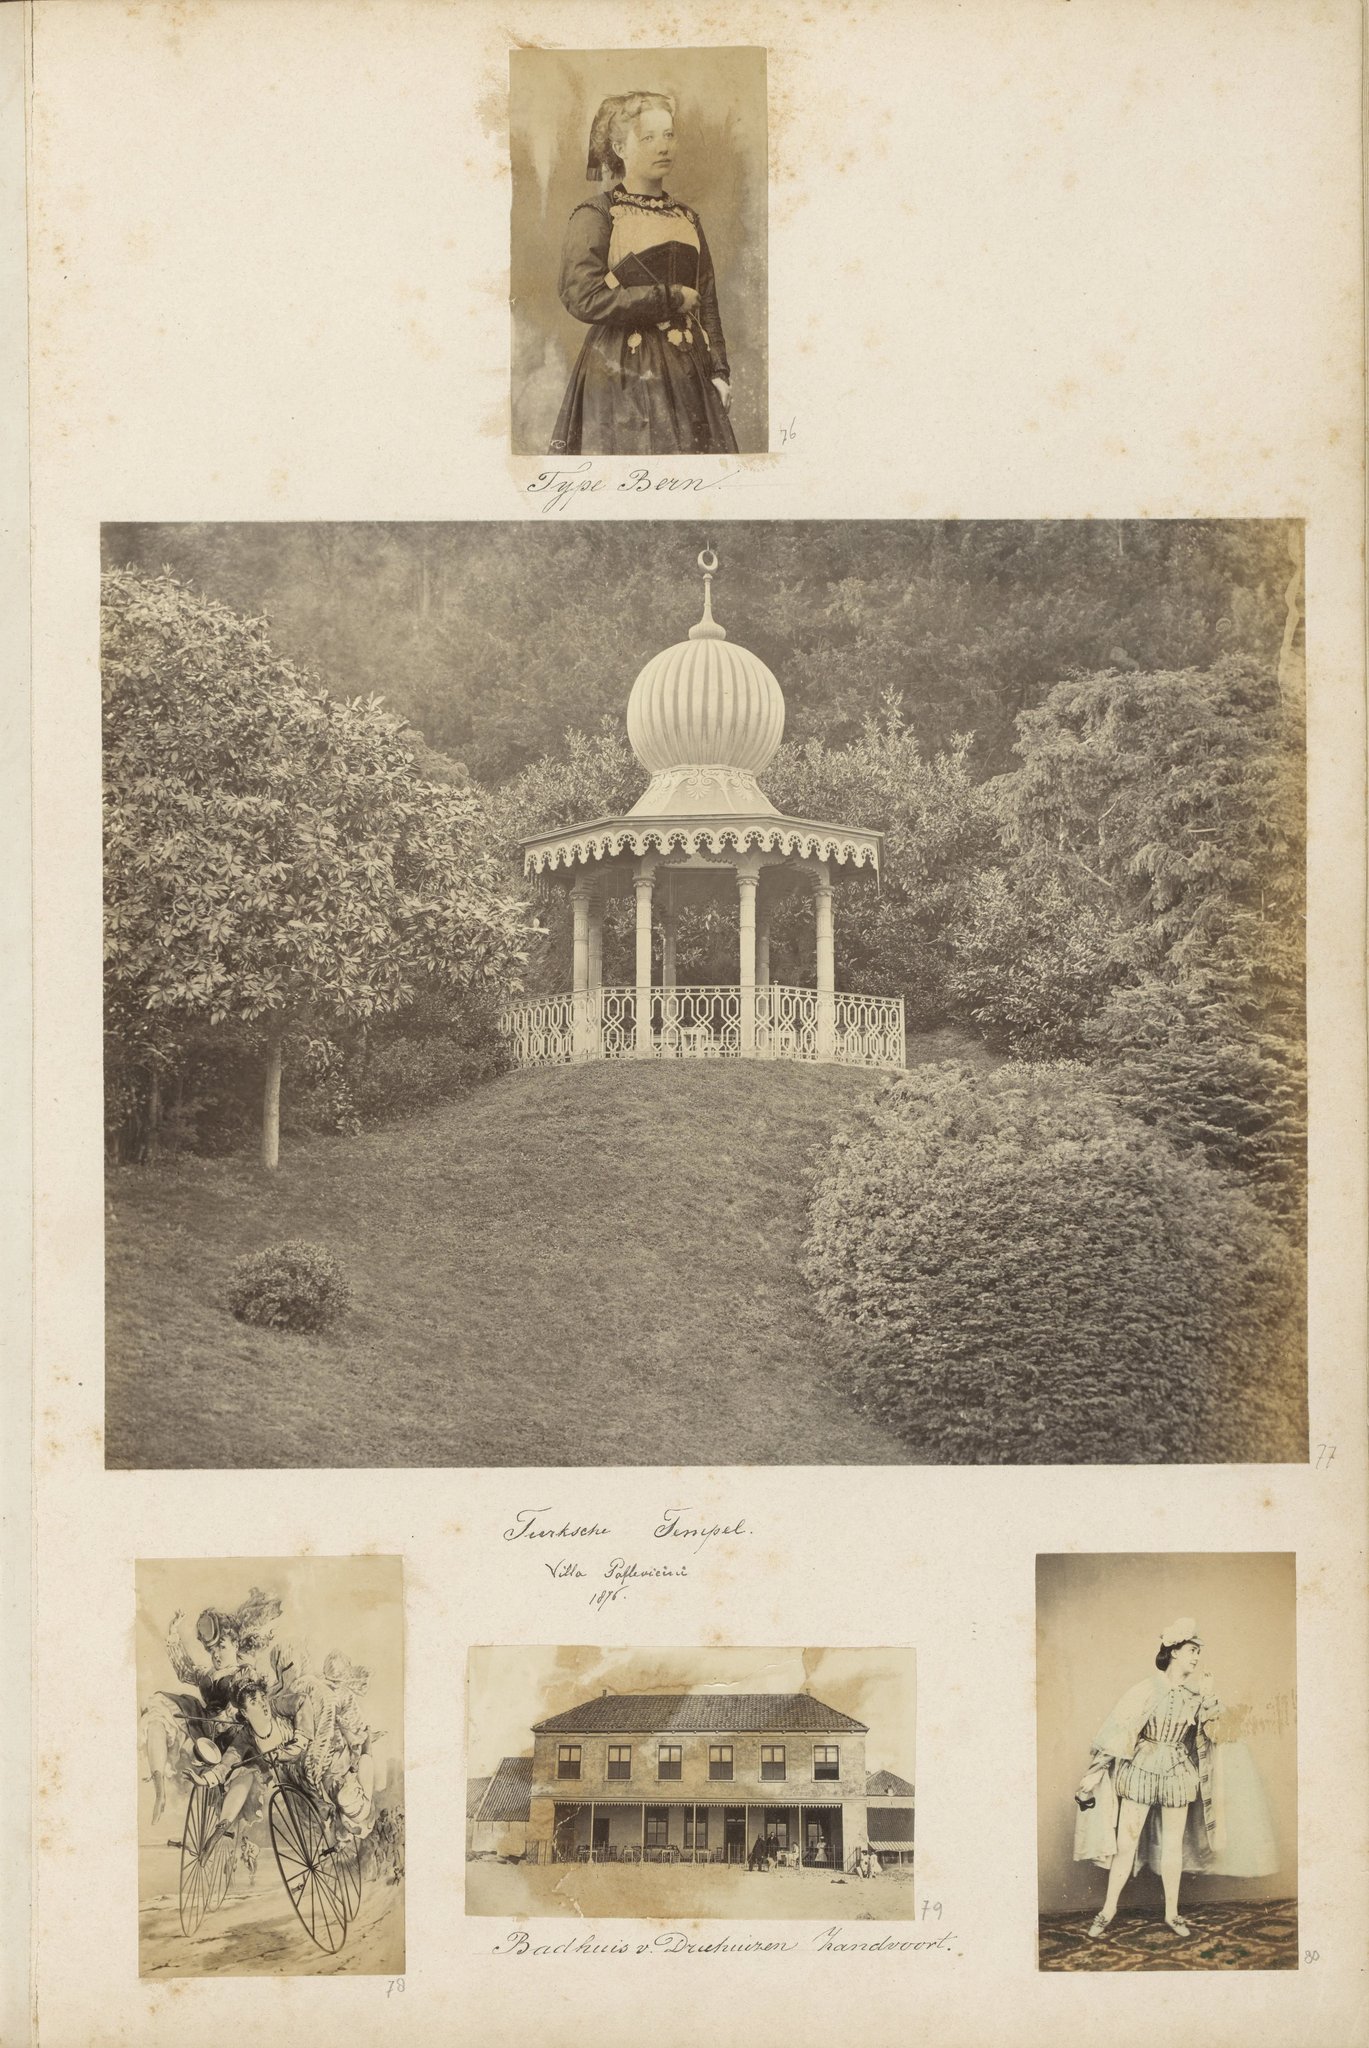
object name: photograph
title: Portret van een vrouw in klederdracht met boek, aangeduid als 'type Bern'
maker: Anonymous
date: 1870-1880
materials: paper, photographic support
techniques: albumen print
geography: switzerland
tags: adult woman, folk costume, regional costume, switzerland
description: Onderdeel van Fotoalbum van Robert Daniel Crommelin (1841-1907).